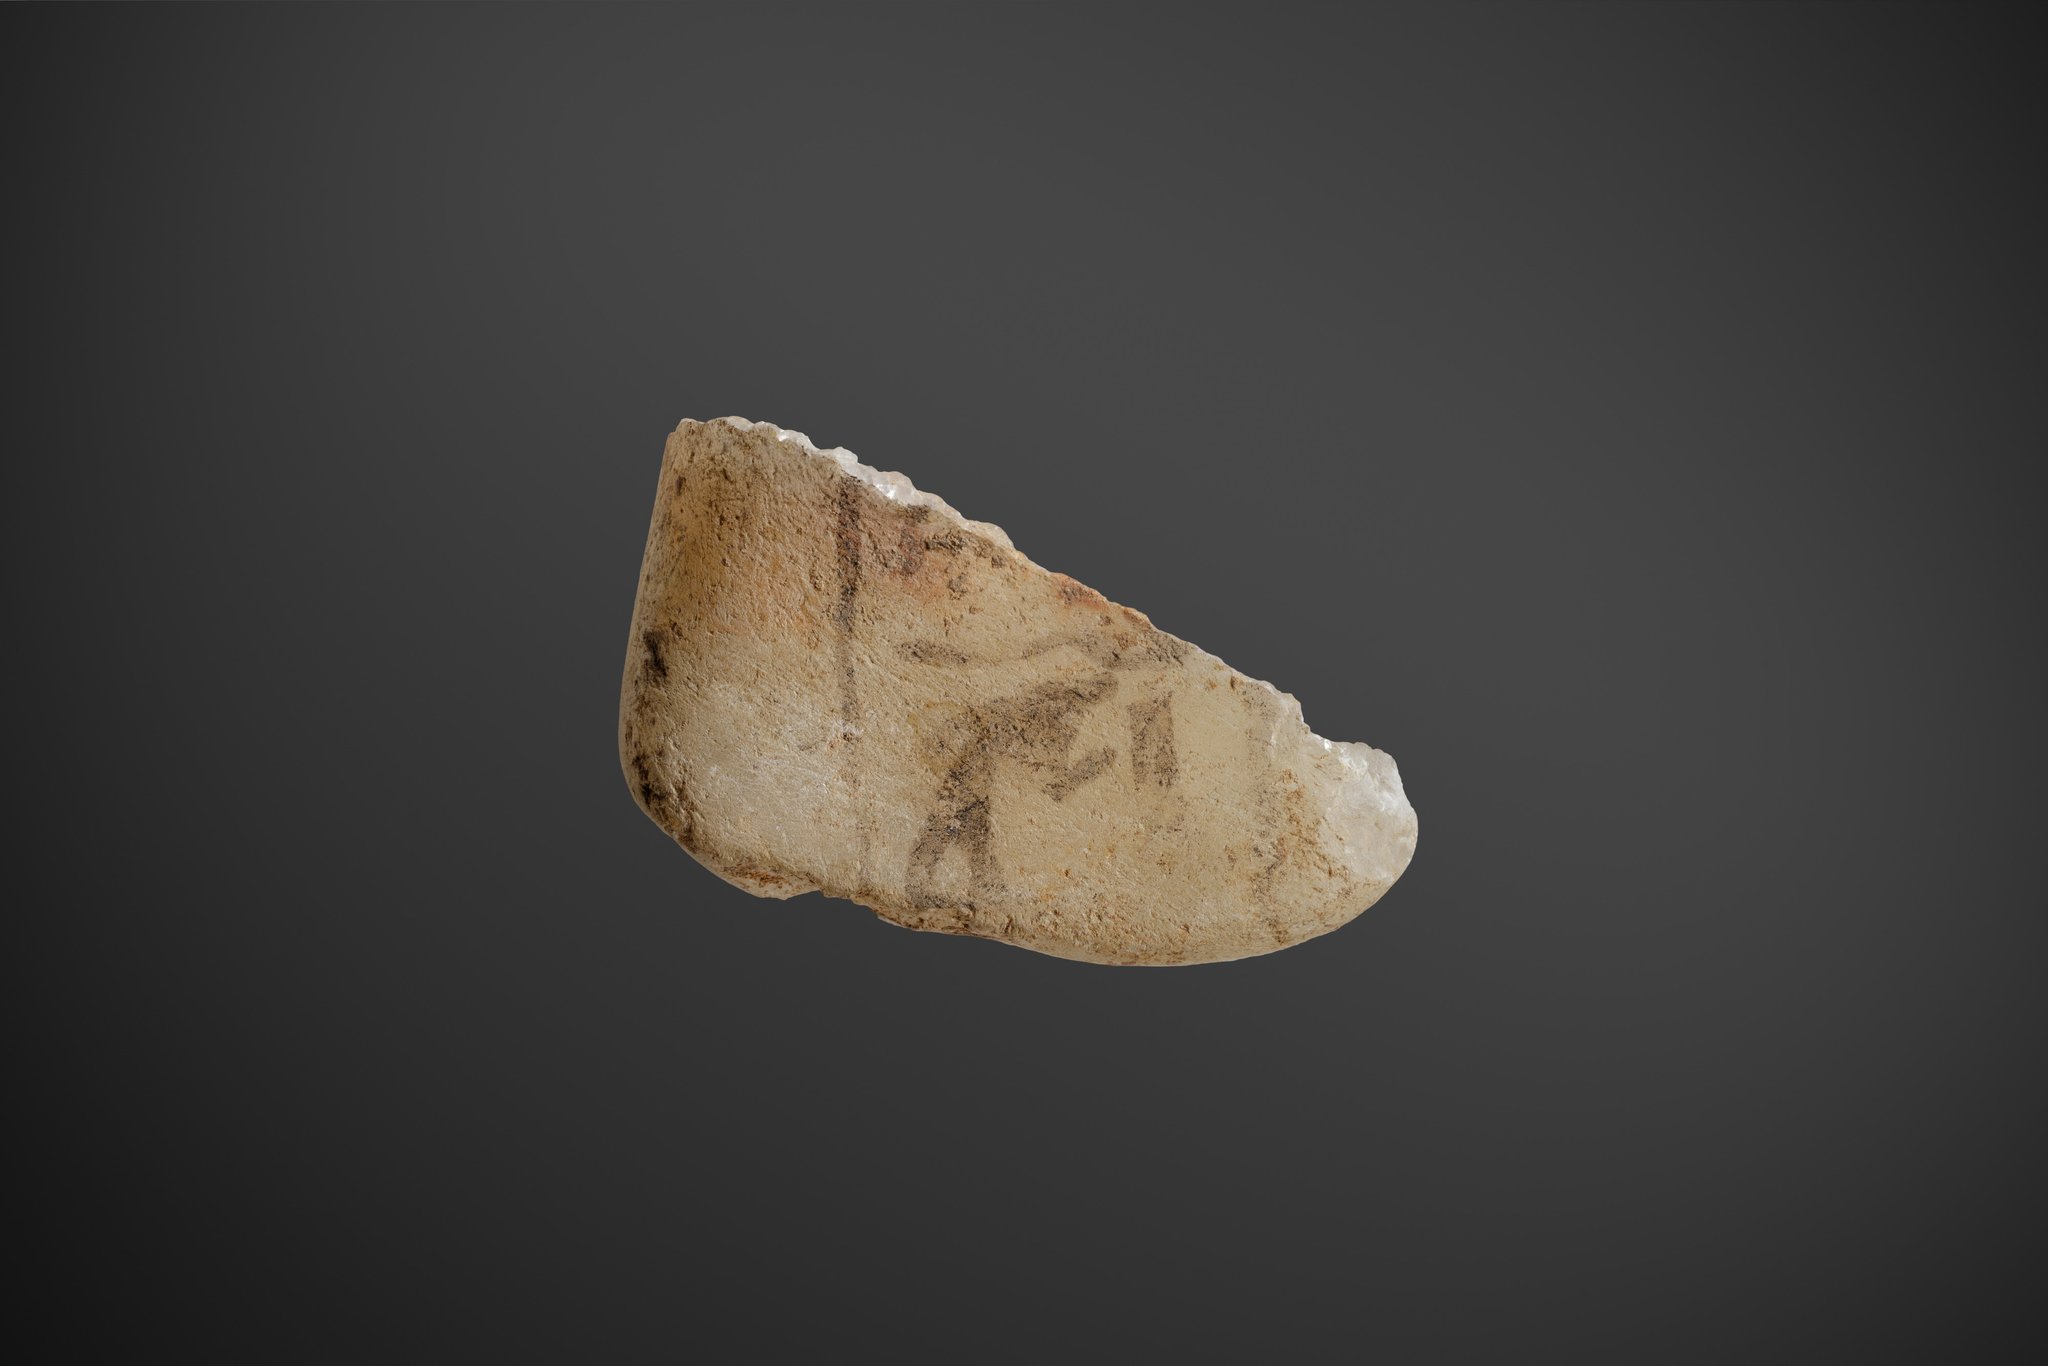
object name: shabti, siptah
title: Shabti of Siptah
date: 1194-1188 BCE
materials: stone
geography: egypt